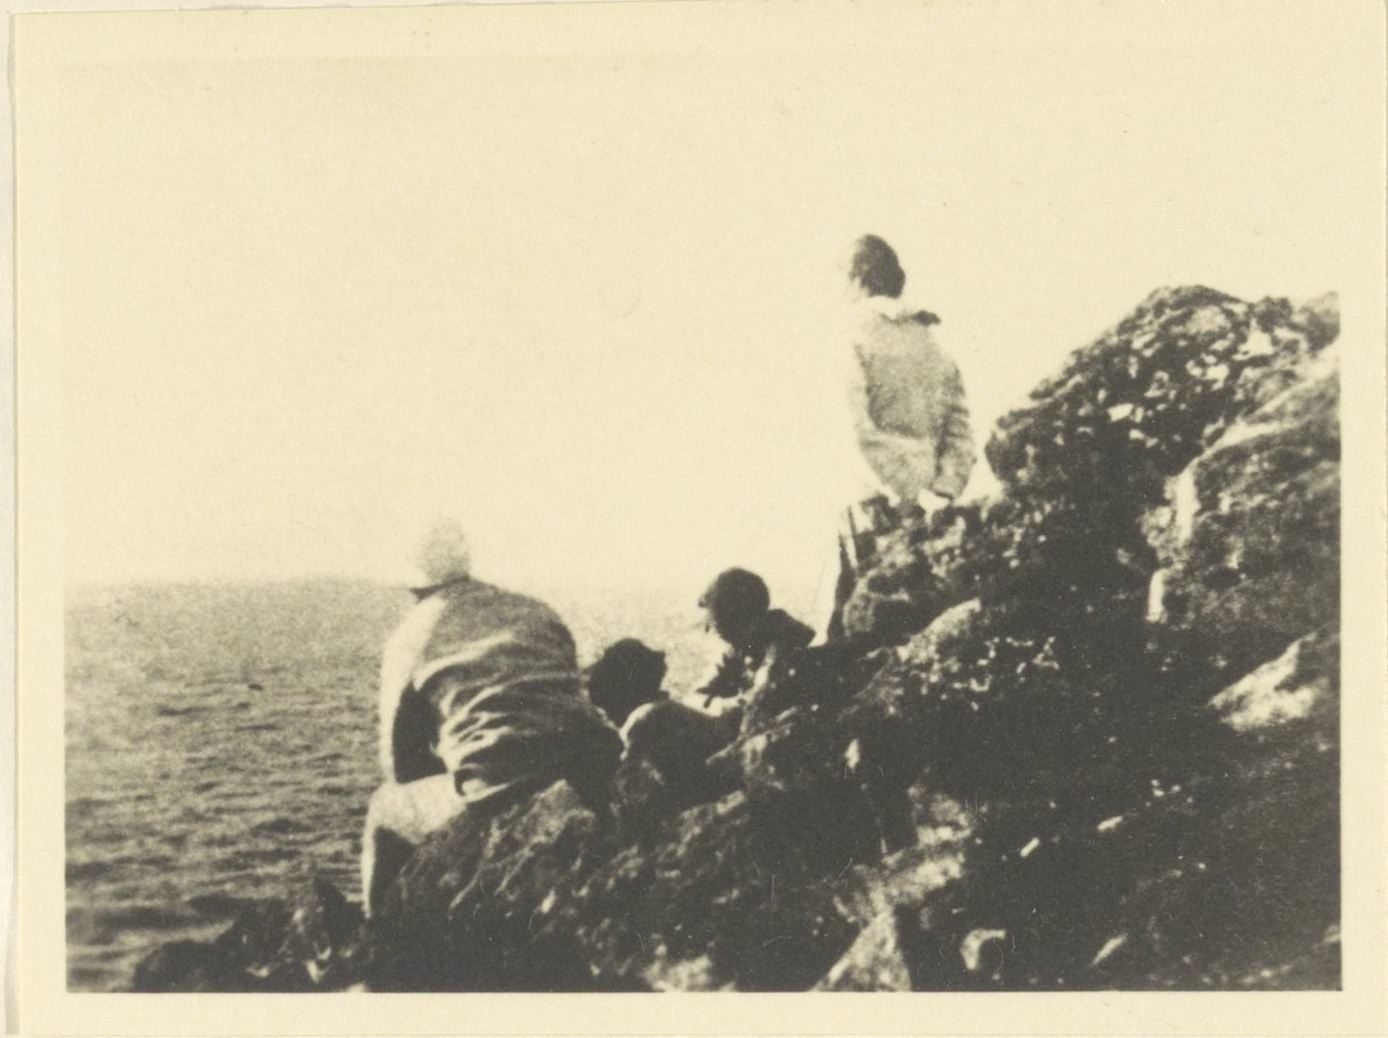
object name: photograph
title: Leerlingen van Schule Schloss Salem tijdens een kampeertocht in Engeland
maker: Anonymous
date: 1928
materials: photographic support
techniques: gelatin silver print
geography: england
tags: tent-camp, education, england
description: Onderdeel van Fotoalbum van Schule Schloss Salem.